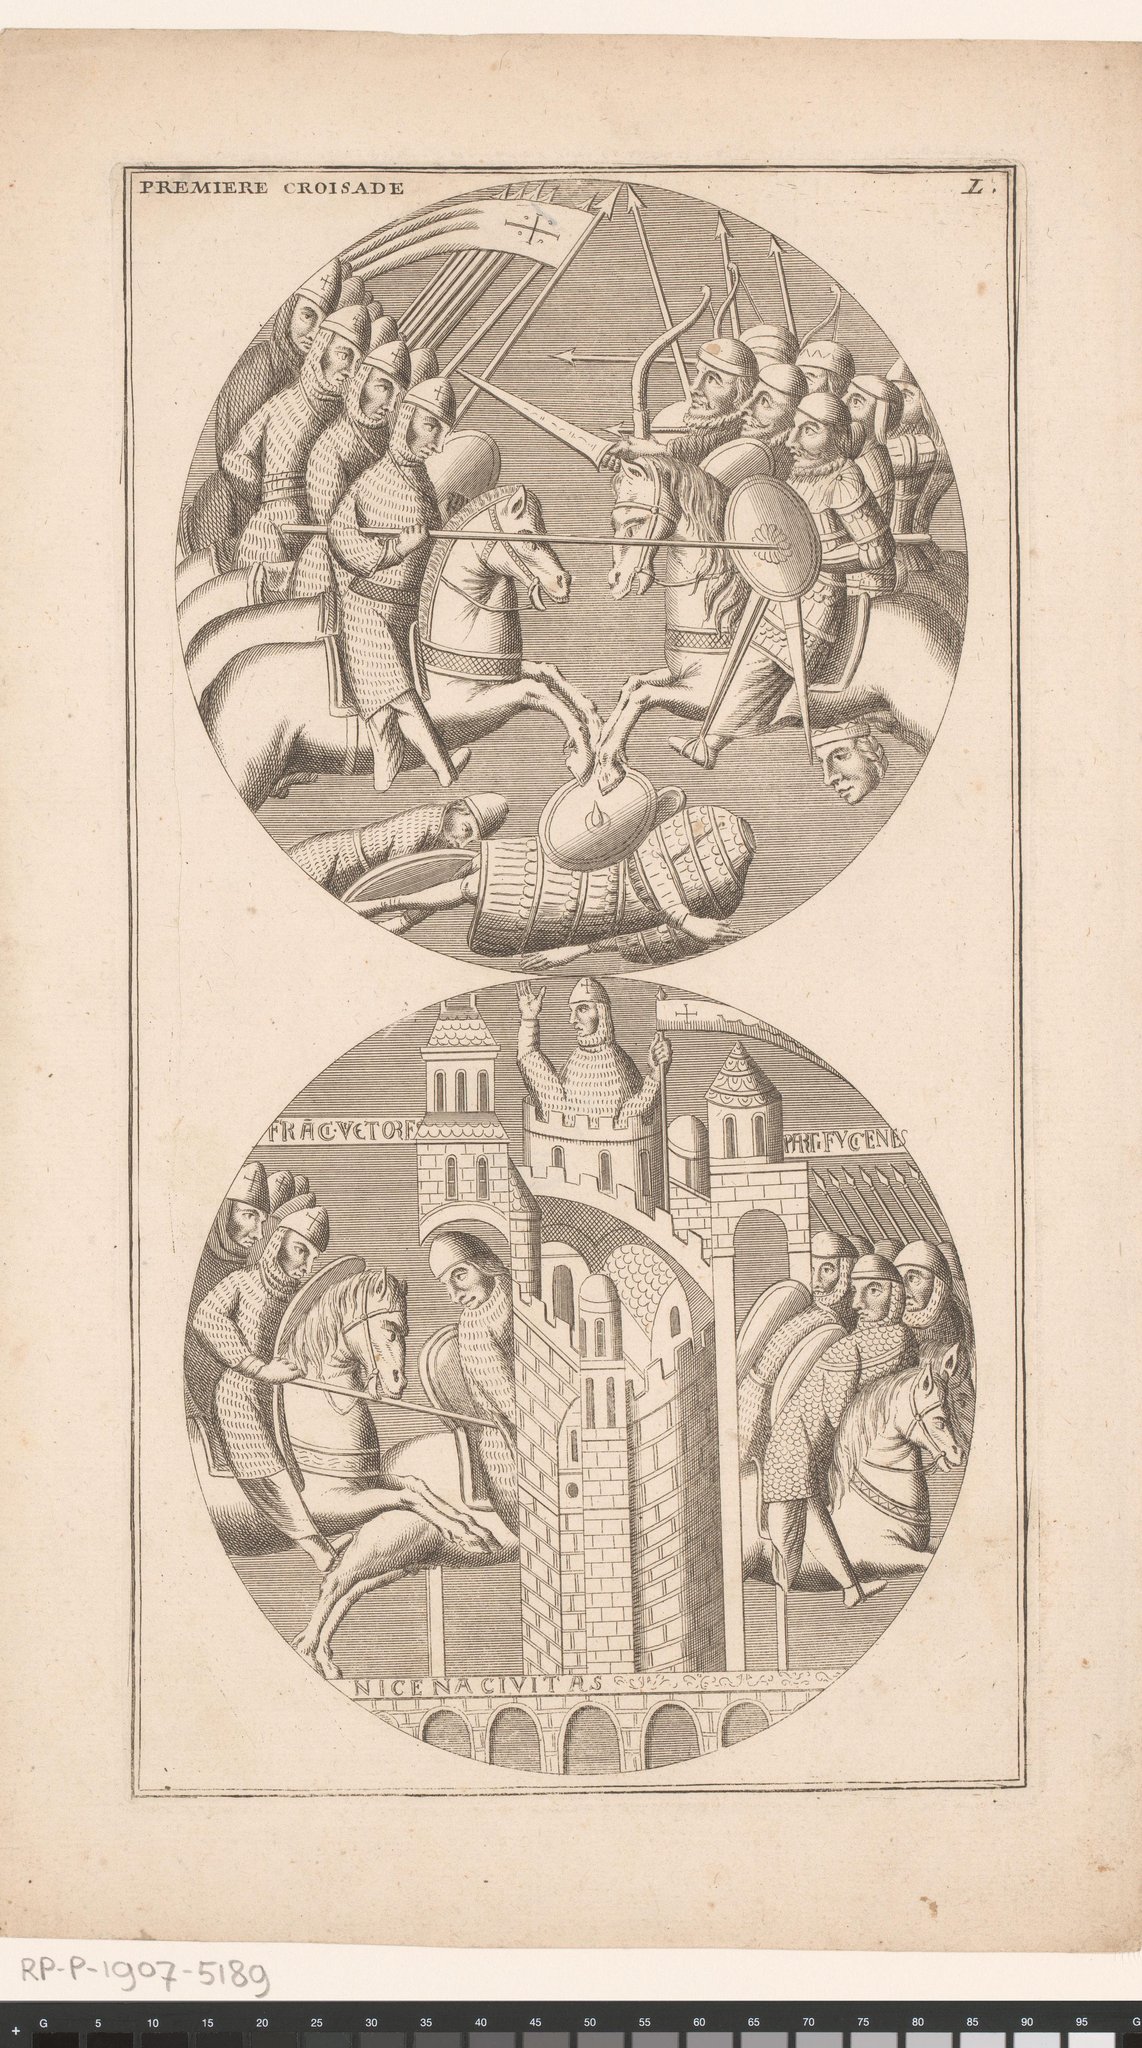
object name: print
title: Twee scènes uit de eerste kruistocht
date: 1729-1733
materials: paper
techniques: engraving, etching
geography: paris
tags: militant proselytizing: religious war, crusade, etc., walls ~ fortified city, knight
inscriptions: collector's mark: Lugt 2228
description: Prent uit: Montfaucon, Bernard de. Les monumens de la monarchie françoise, qui comprennent l'histoire de France avec les figures de chaque règne que l'injure des tems a épargnées (...). Parijs: Julien-Michel Gandouin en Pierre-François Giffart, 1729-1733, dl. 1, afb. voor p. 391.